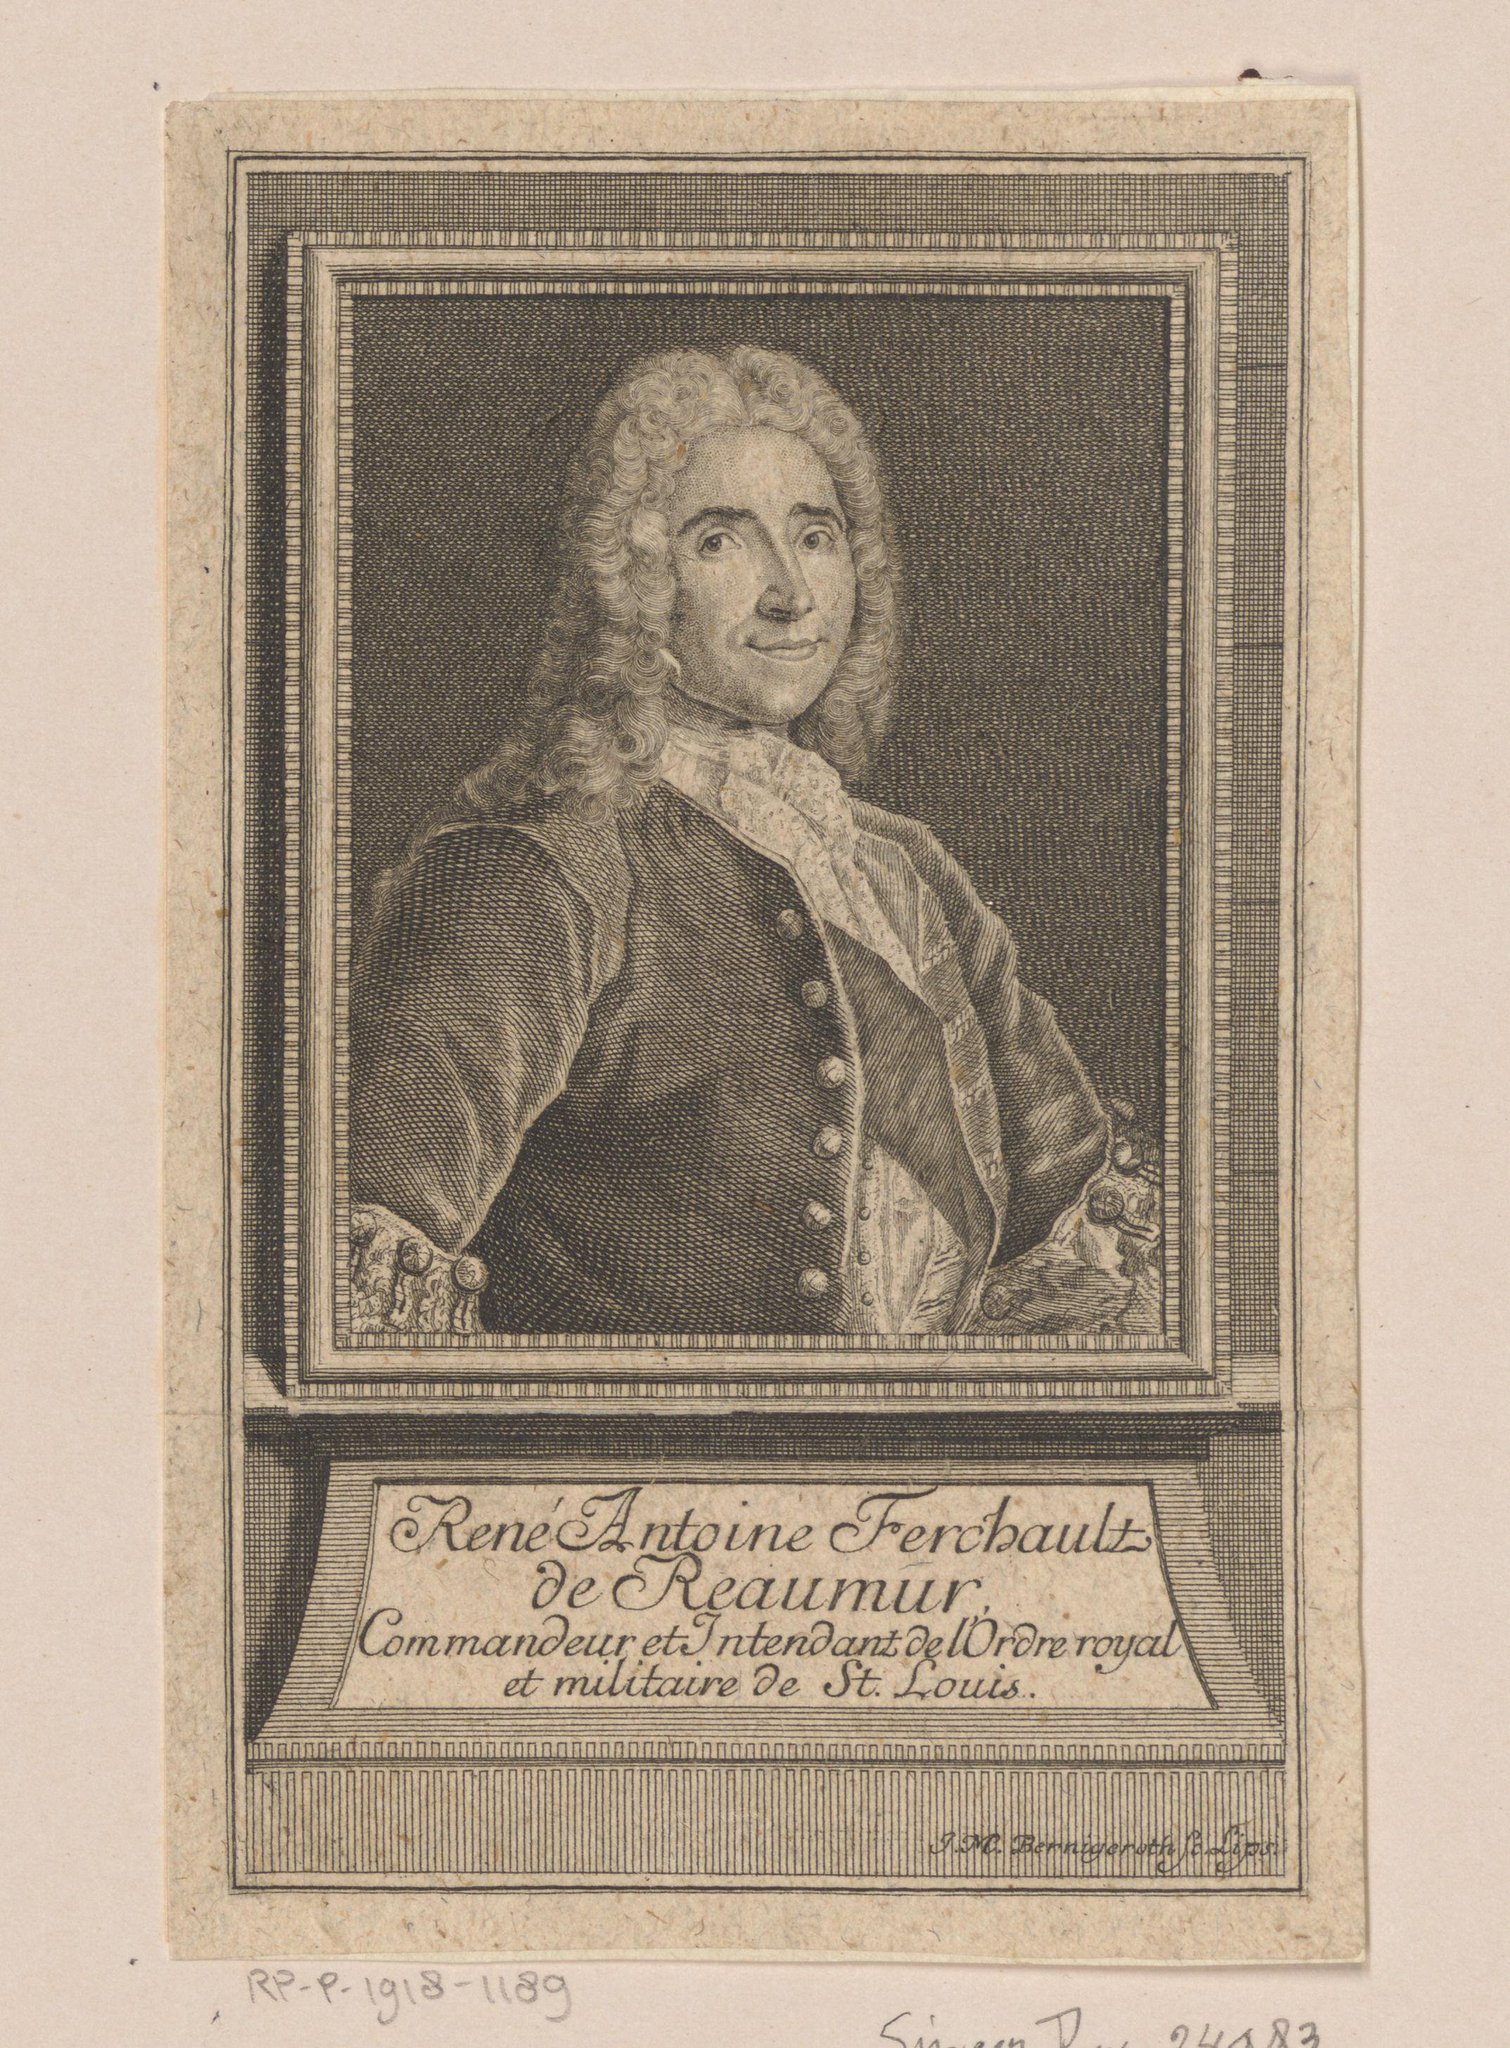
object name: print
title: Portret van René-Antoine Ferchault de Réaumur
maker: johann martin bernigeroth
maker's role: print maker, publisher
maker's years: 1713-1767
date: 1723-1767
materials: paper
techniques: etching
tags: historical persons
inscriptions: collector's mark: Lugt 2233